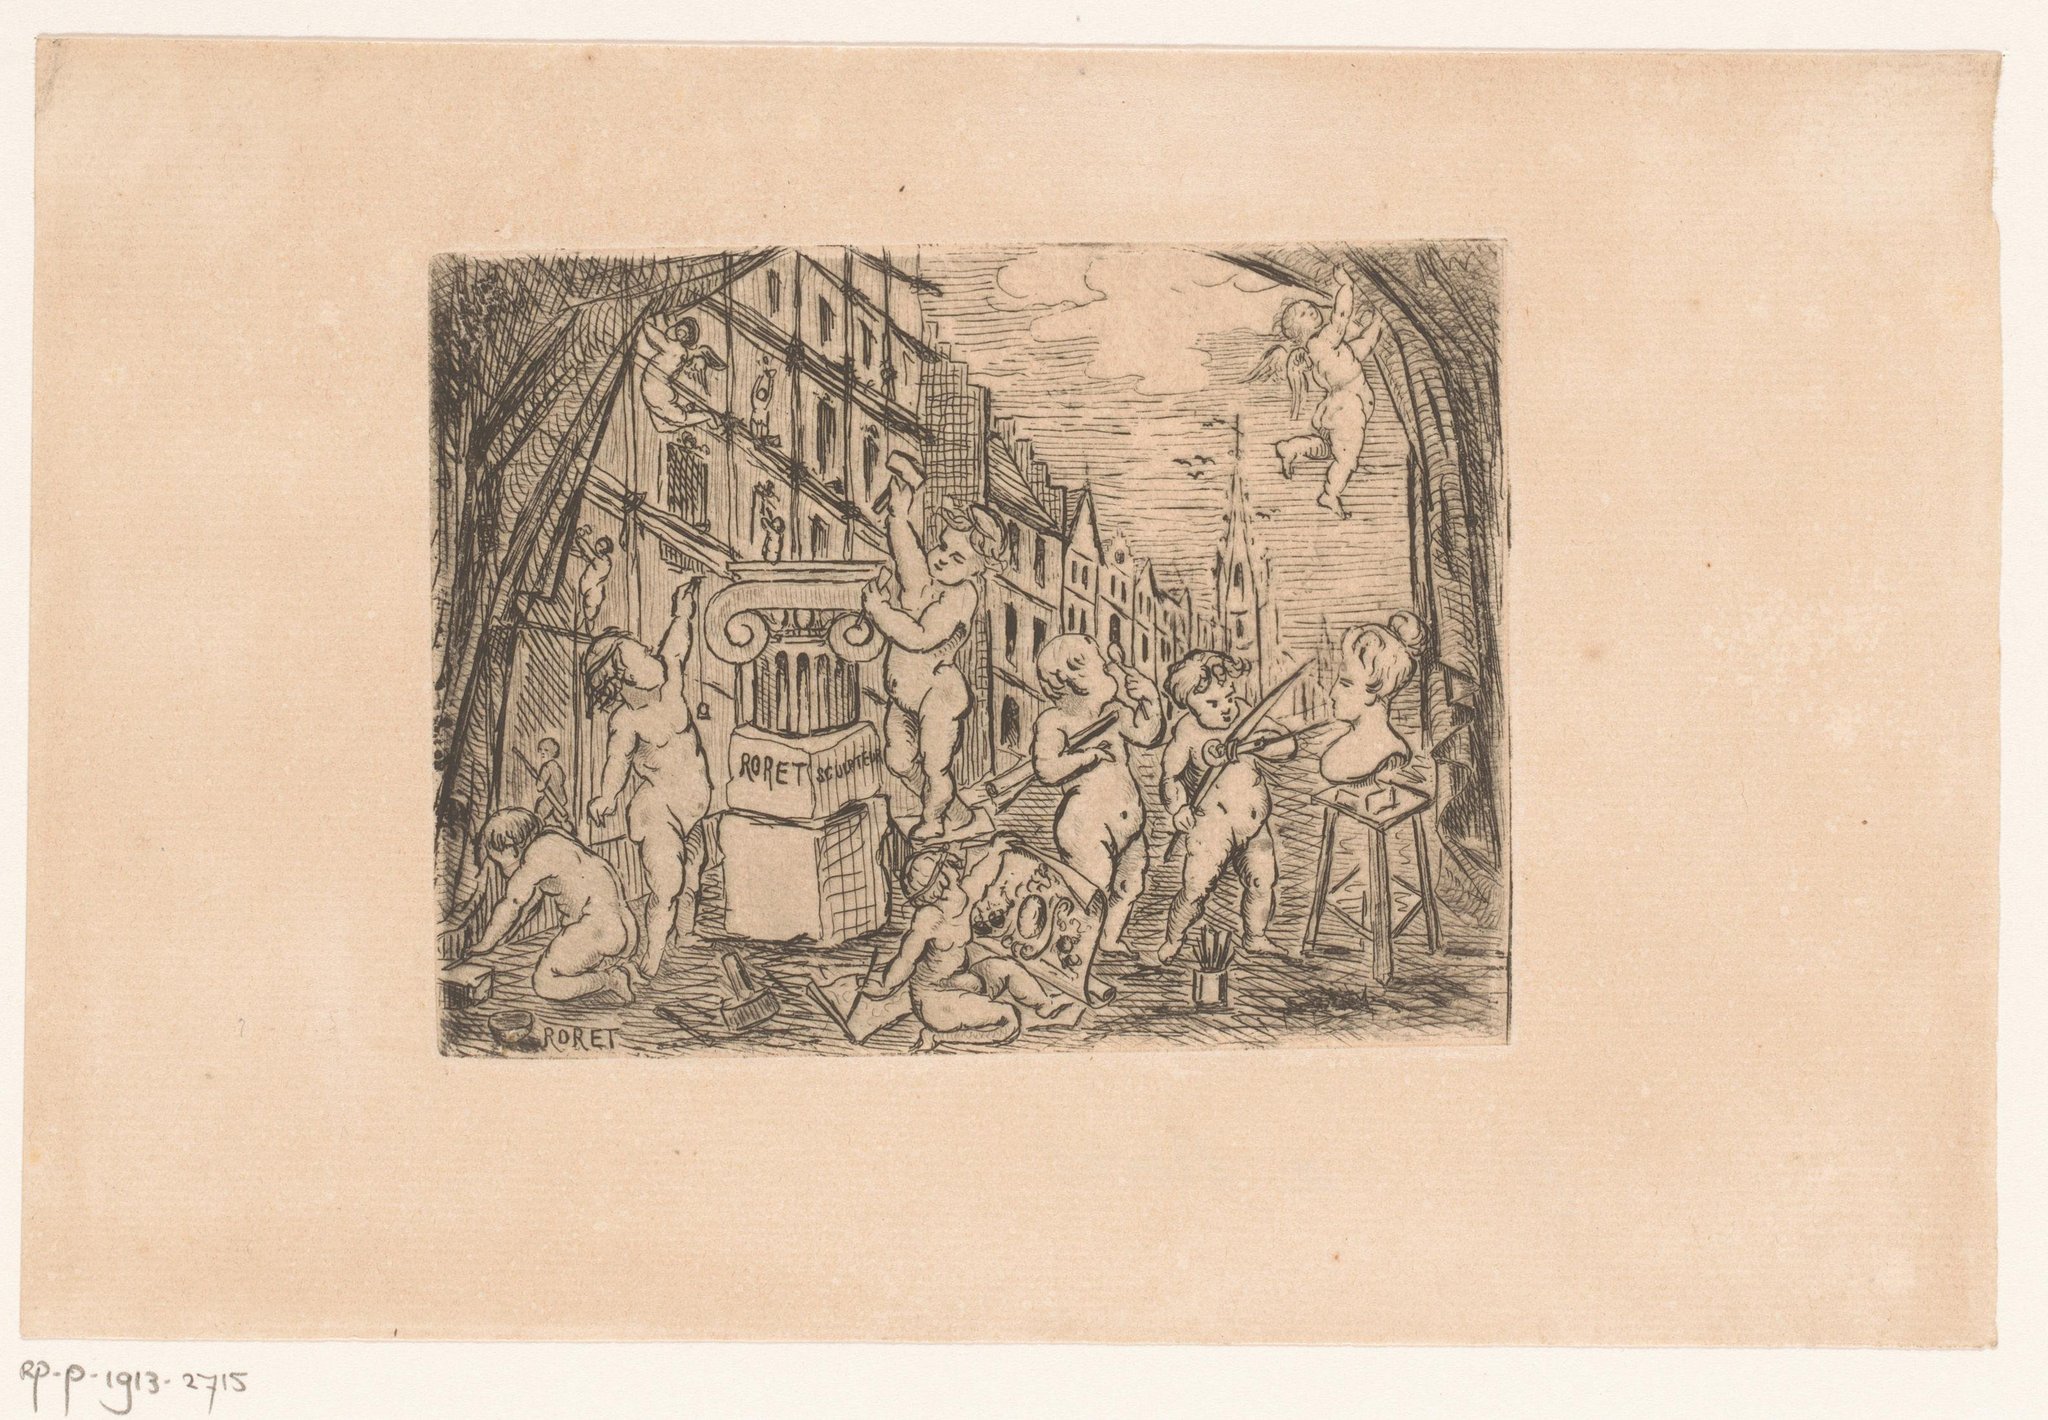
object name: print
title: Roret sculpteur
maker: a. roret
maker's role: print maker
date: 1800-1913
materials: paper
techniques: etching, intaglio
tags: sculpture, cupids: 'amores', 'amoretti', 'putti'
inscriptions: collector's mark: Lugt 2228